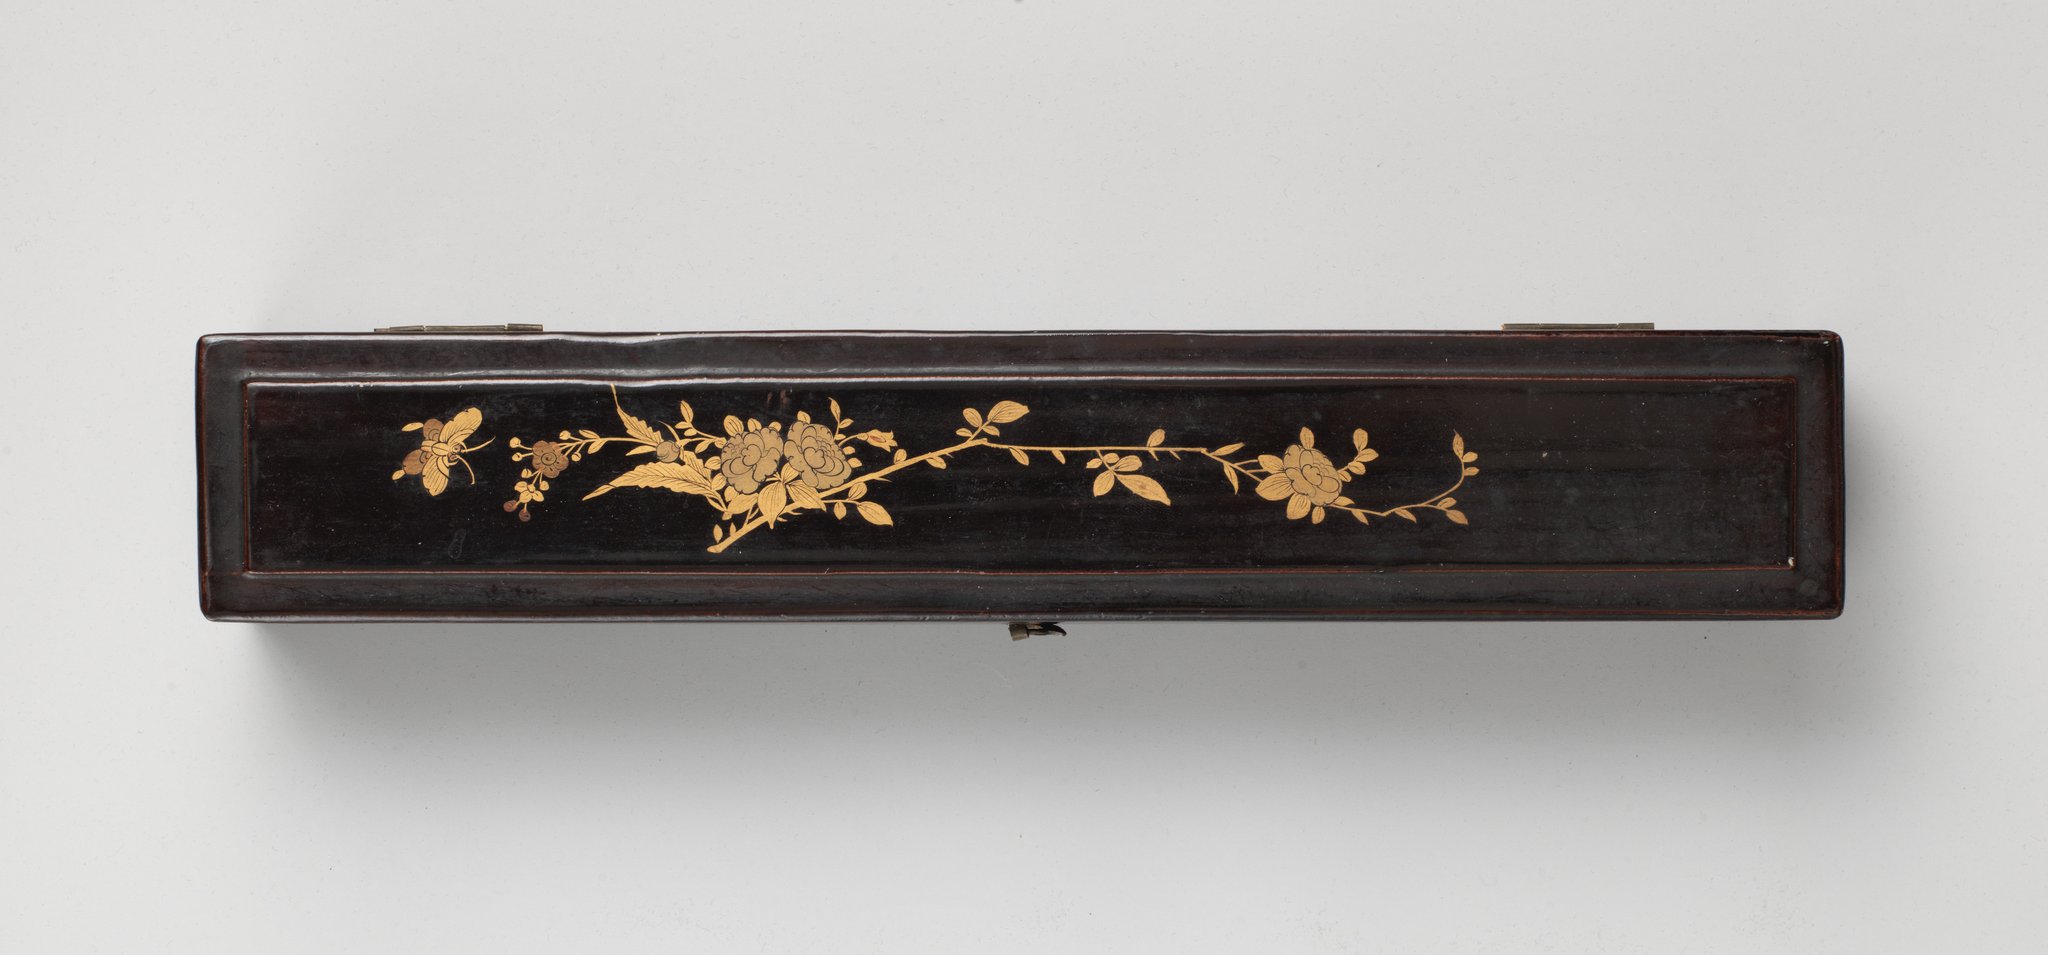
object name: fan box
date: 1801-1900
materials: paper, silk, wood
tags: butterflies,flowers